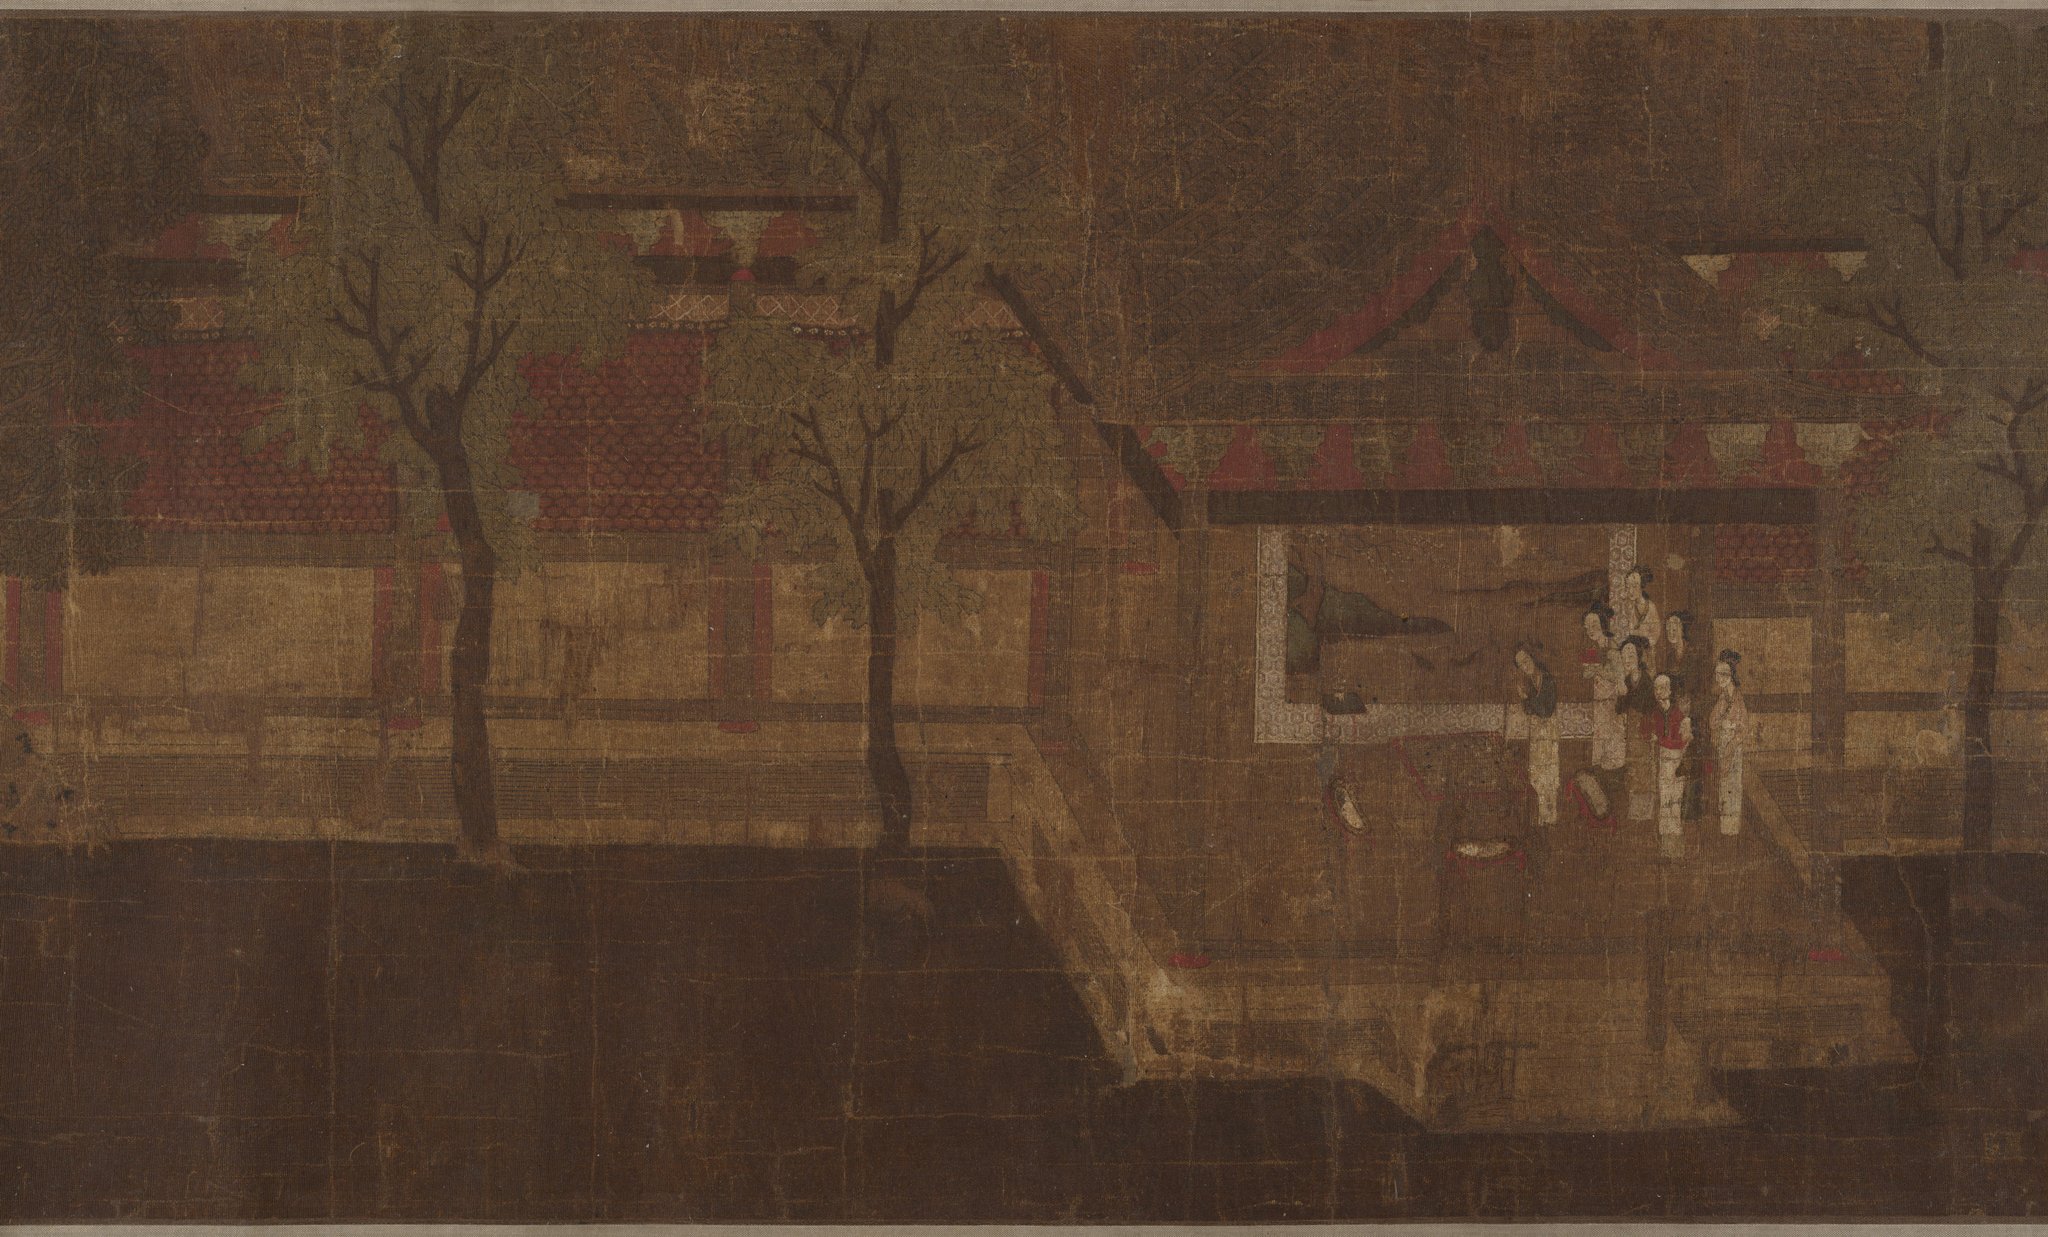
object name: handscroll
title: Pavilion with Figures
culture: chinese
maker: unidentified artist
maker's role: artist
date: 906-1279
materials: ink, silk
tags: women,games,pavilions